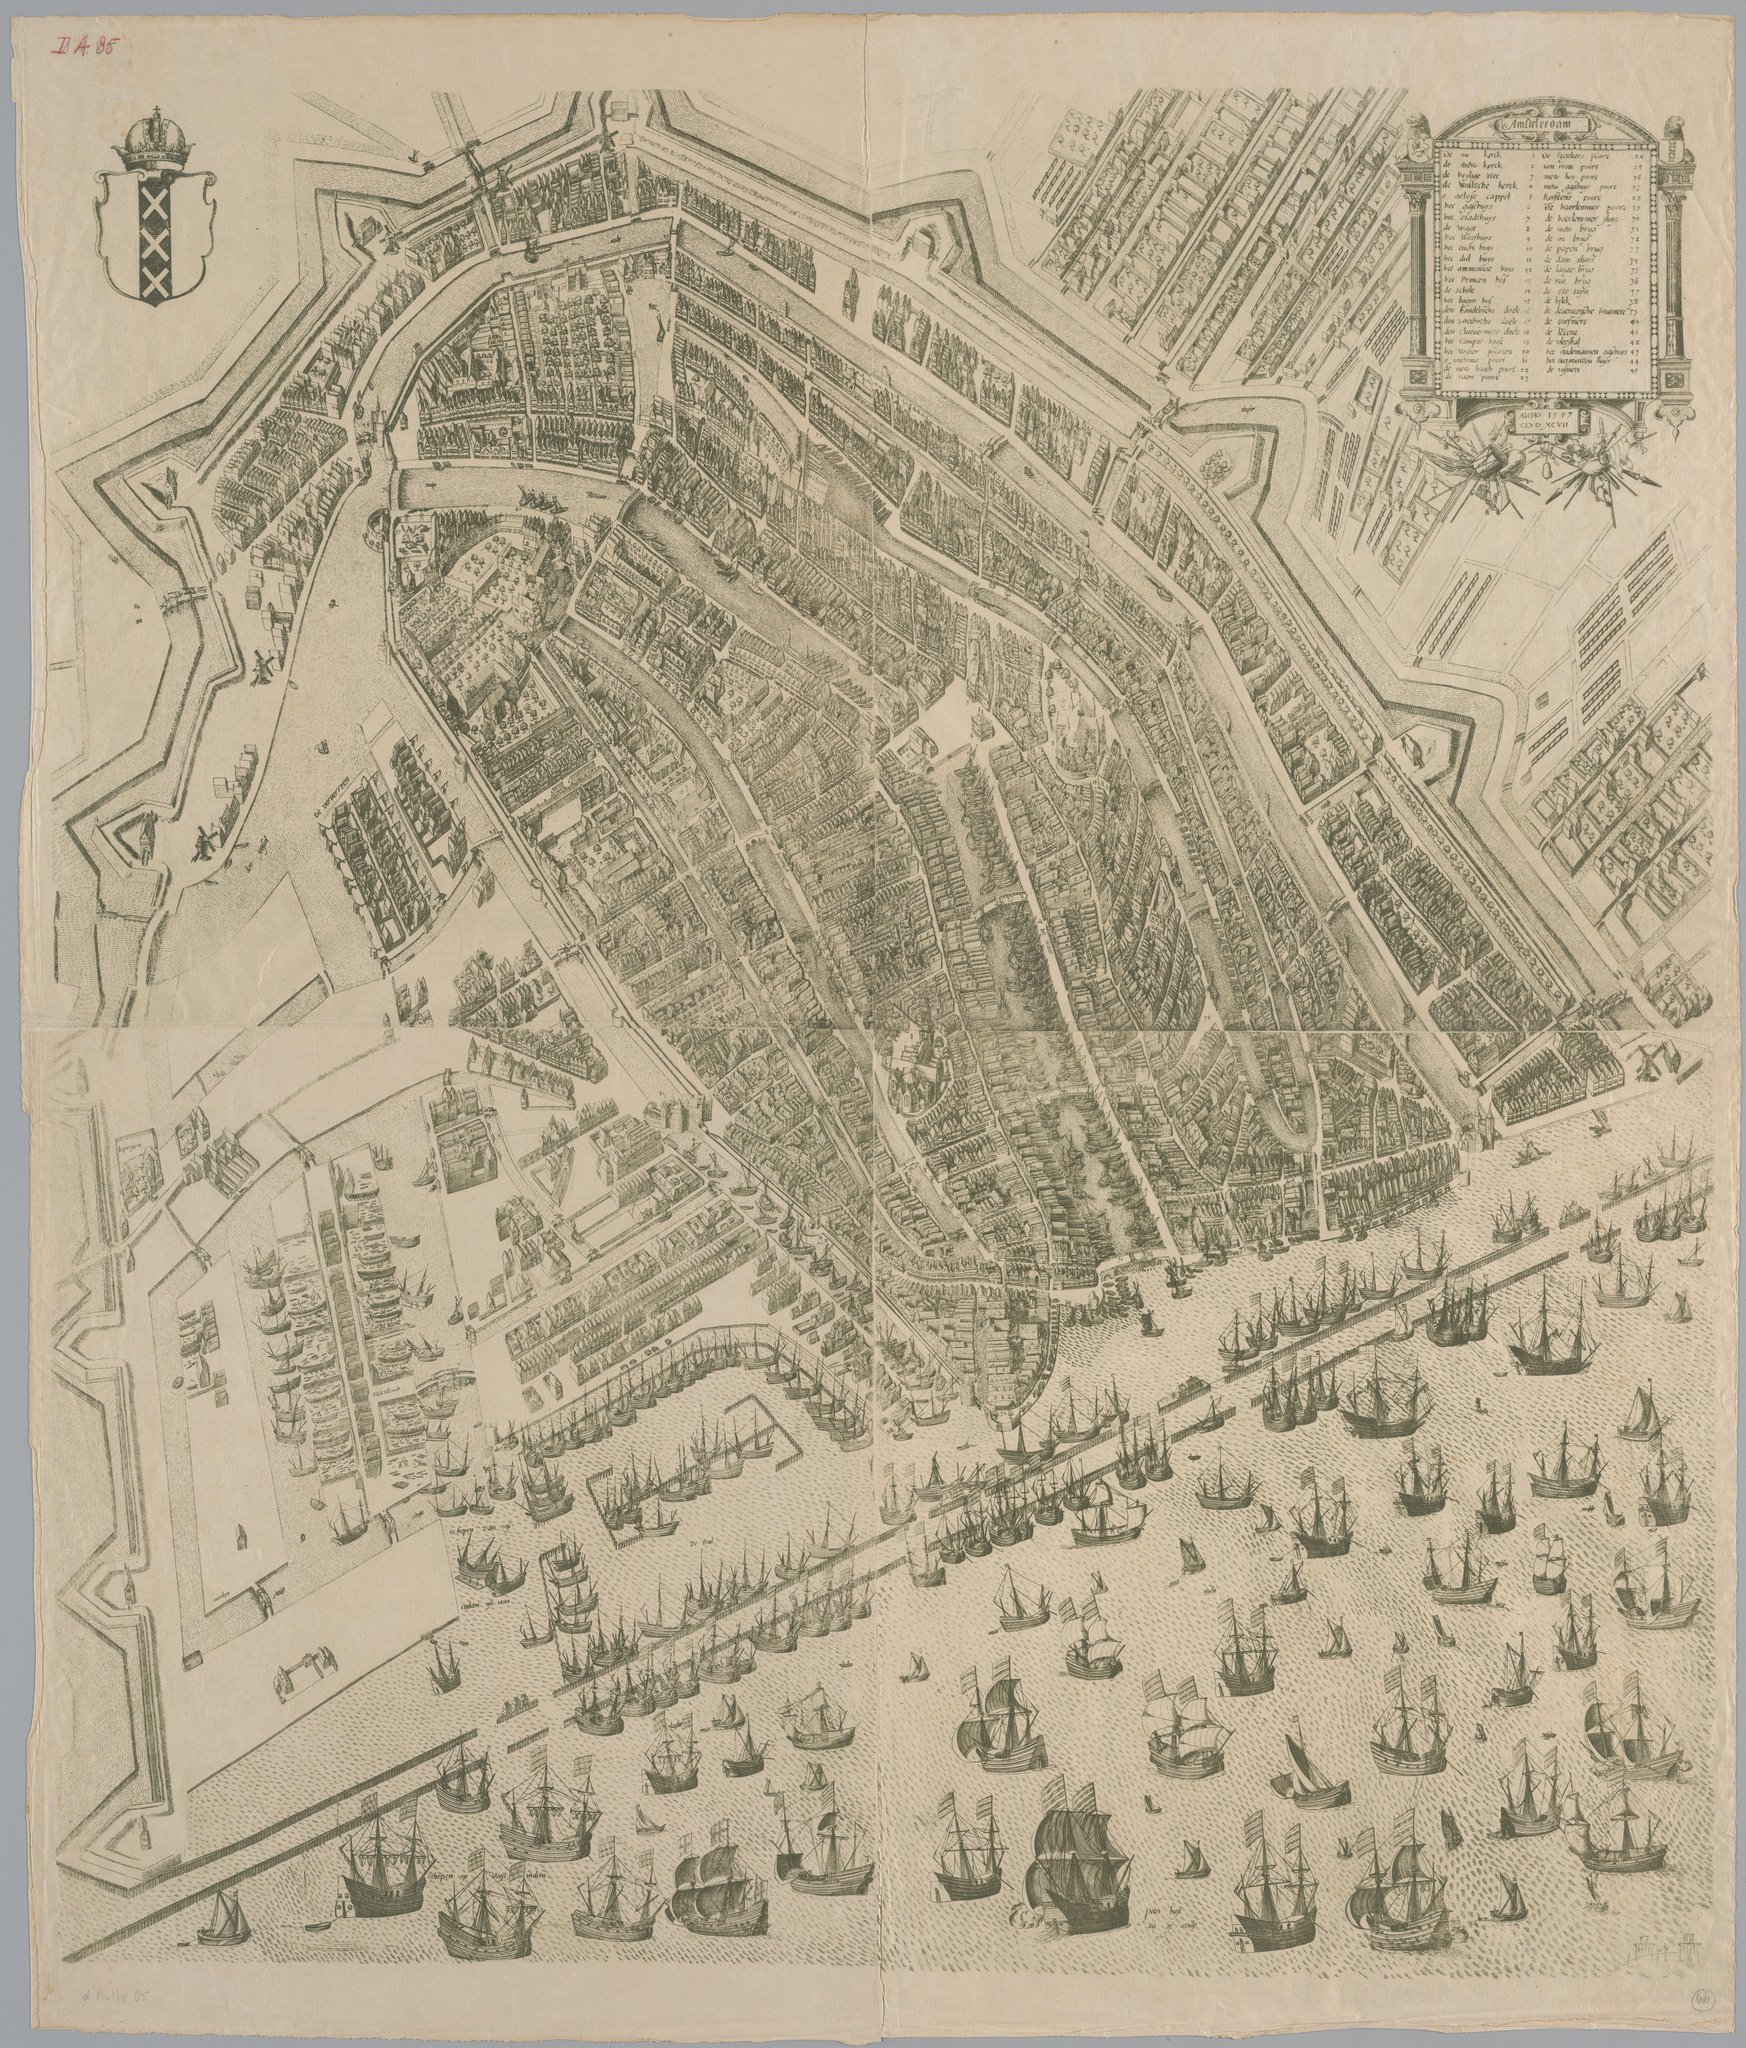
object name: area plan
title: Reproductie van de plattegrond van Amsterdam door Pieter Bast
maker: Anonymous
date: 1916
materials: paper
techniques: photoaquatint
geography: amsterdam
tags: coat of arms (as symbol of the state, etc.) (+ city; municipal), maps of cities, amsterdam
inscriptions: collector's mark: Lugt 1641b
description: Object bestaat uit vier aan elkaar geplakte bladen.